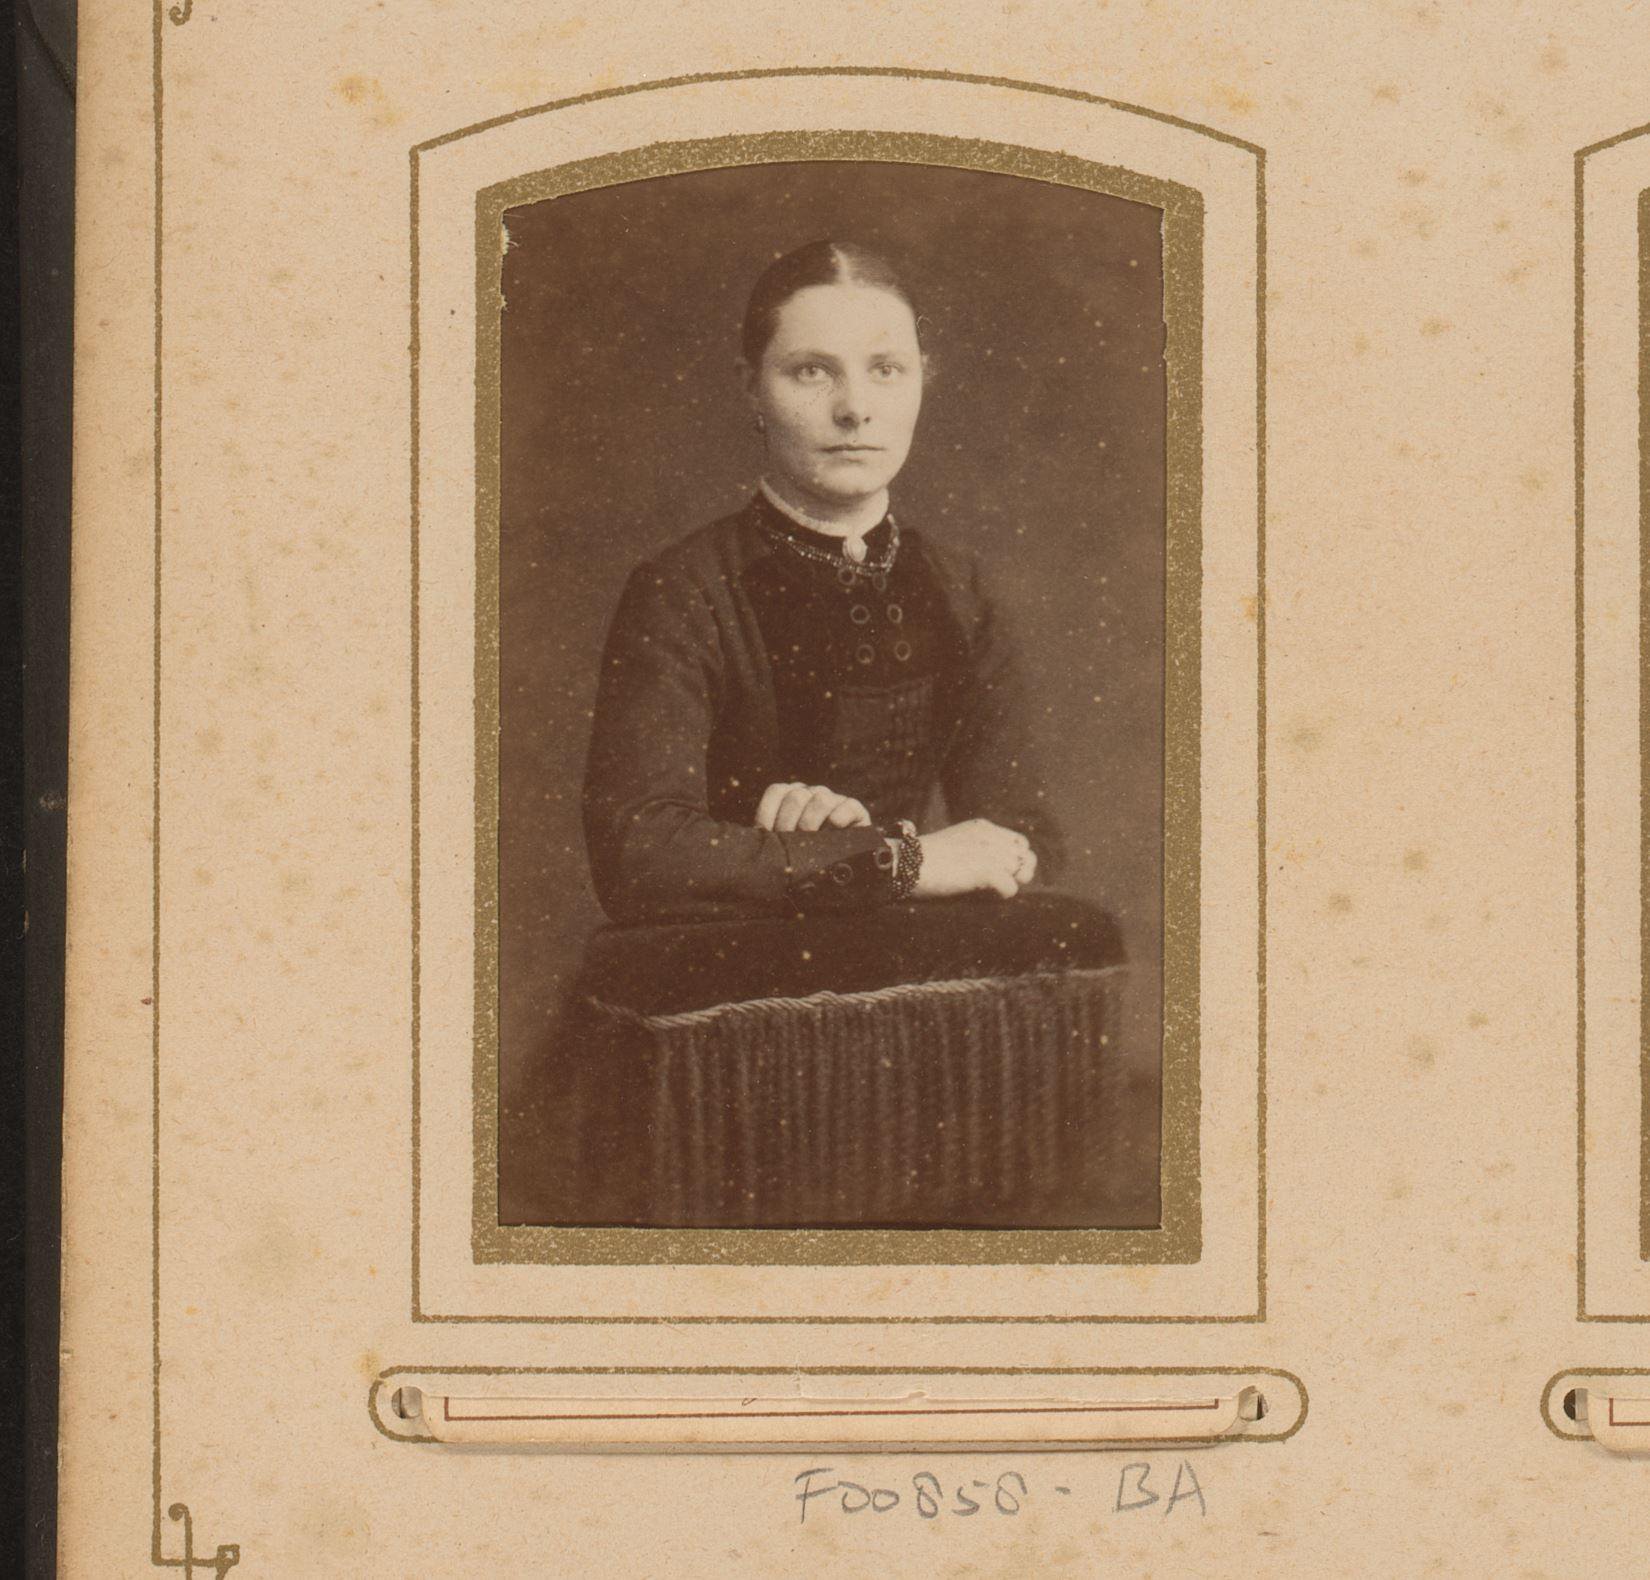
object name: photograph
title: Portret van een meisje, leunend op een stoel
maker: albert a. kleintjes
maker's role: fotograaf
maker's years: 1854-1942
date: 1883-1900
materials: cardboard, photographic support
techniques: albumen print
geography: hoorn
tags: girl (child between toddler and youth)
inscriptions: inscription: ‘Hoorn, Kerkstraat, 4e huis v.d. Kaasmarkt’